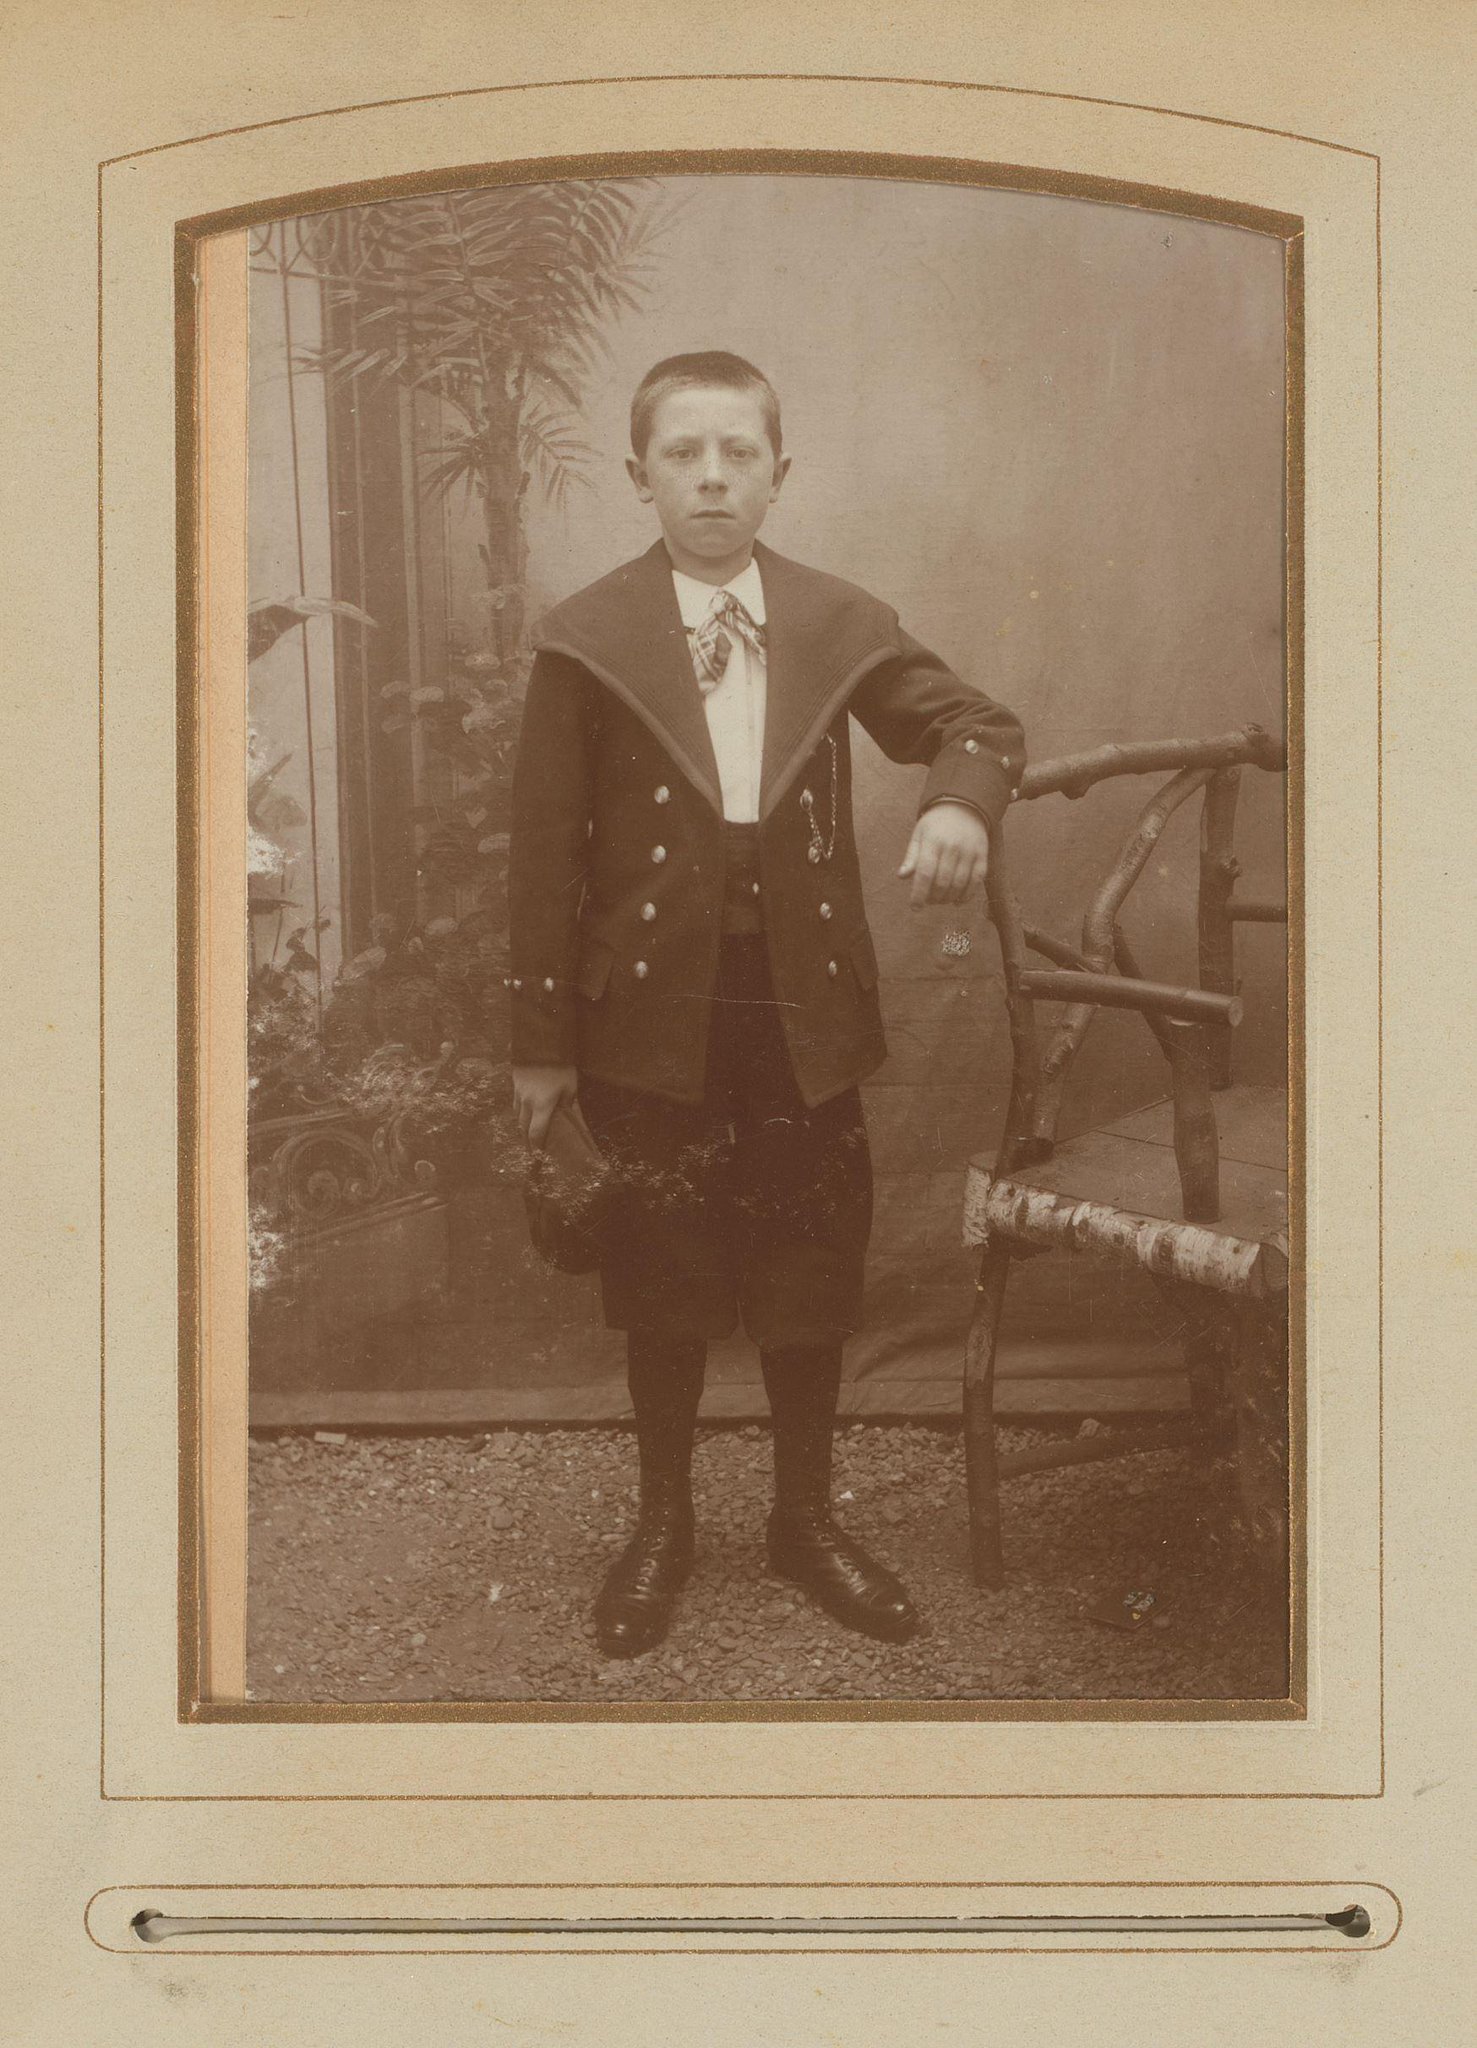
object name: cabinet photograph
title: Portret van een jongen, staand bij een stoel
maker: jacobus franciscus louis muller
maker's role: fotograaf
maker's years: 1870-1924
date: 1897-1899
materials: cardboard, photographic support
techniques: collodion silver print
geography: the hague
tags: boy (child between toddler and youth), historical persons, chair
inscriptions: inscription: ‘A. C. CORDES/ Cuijpstraat 55/ DEN HAAG.’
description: A.C. Cordes is een pseudoniem voor fotograaf Jacobus Franciscus Louis Muller. Hij gebruikte hiervoor de naam van zijn vrouw Adriana Catharina Cordes.